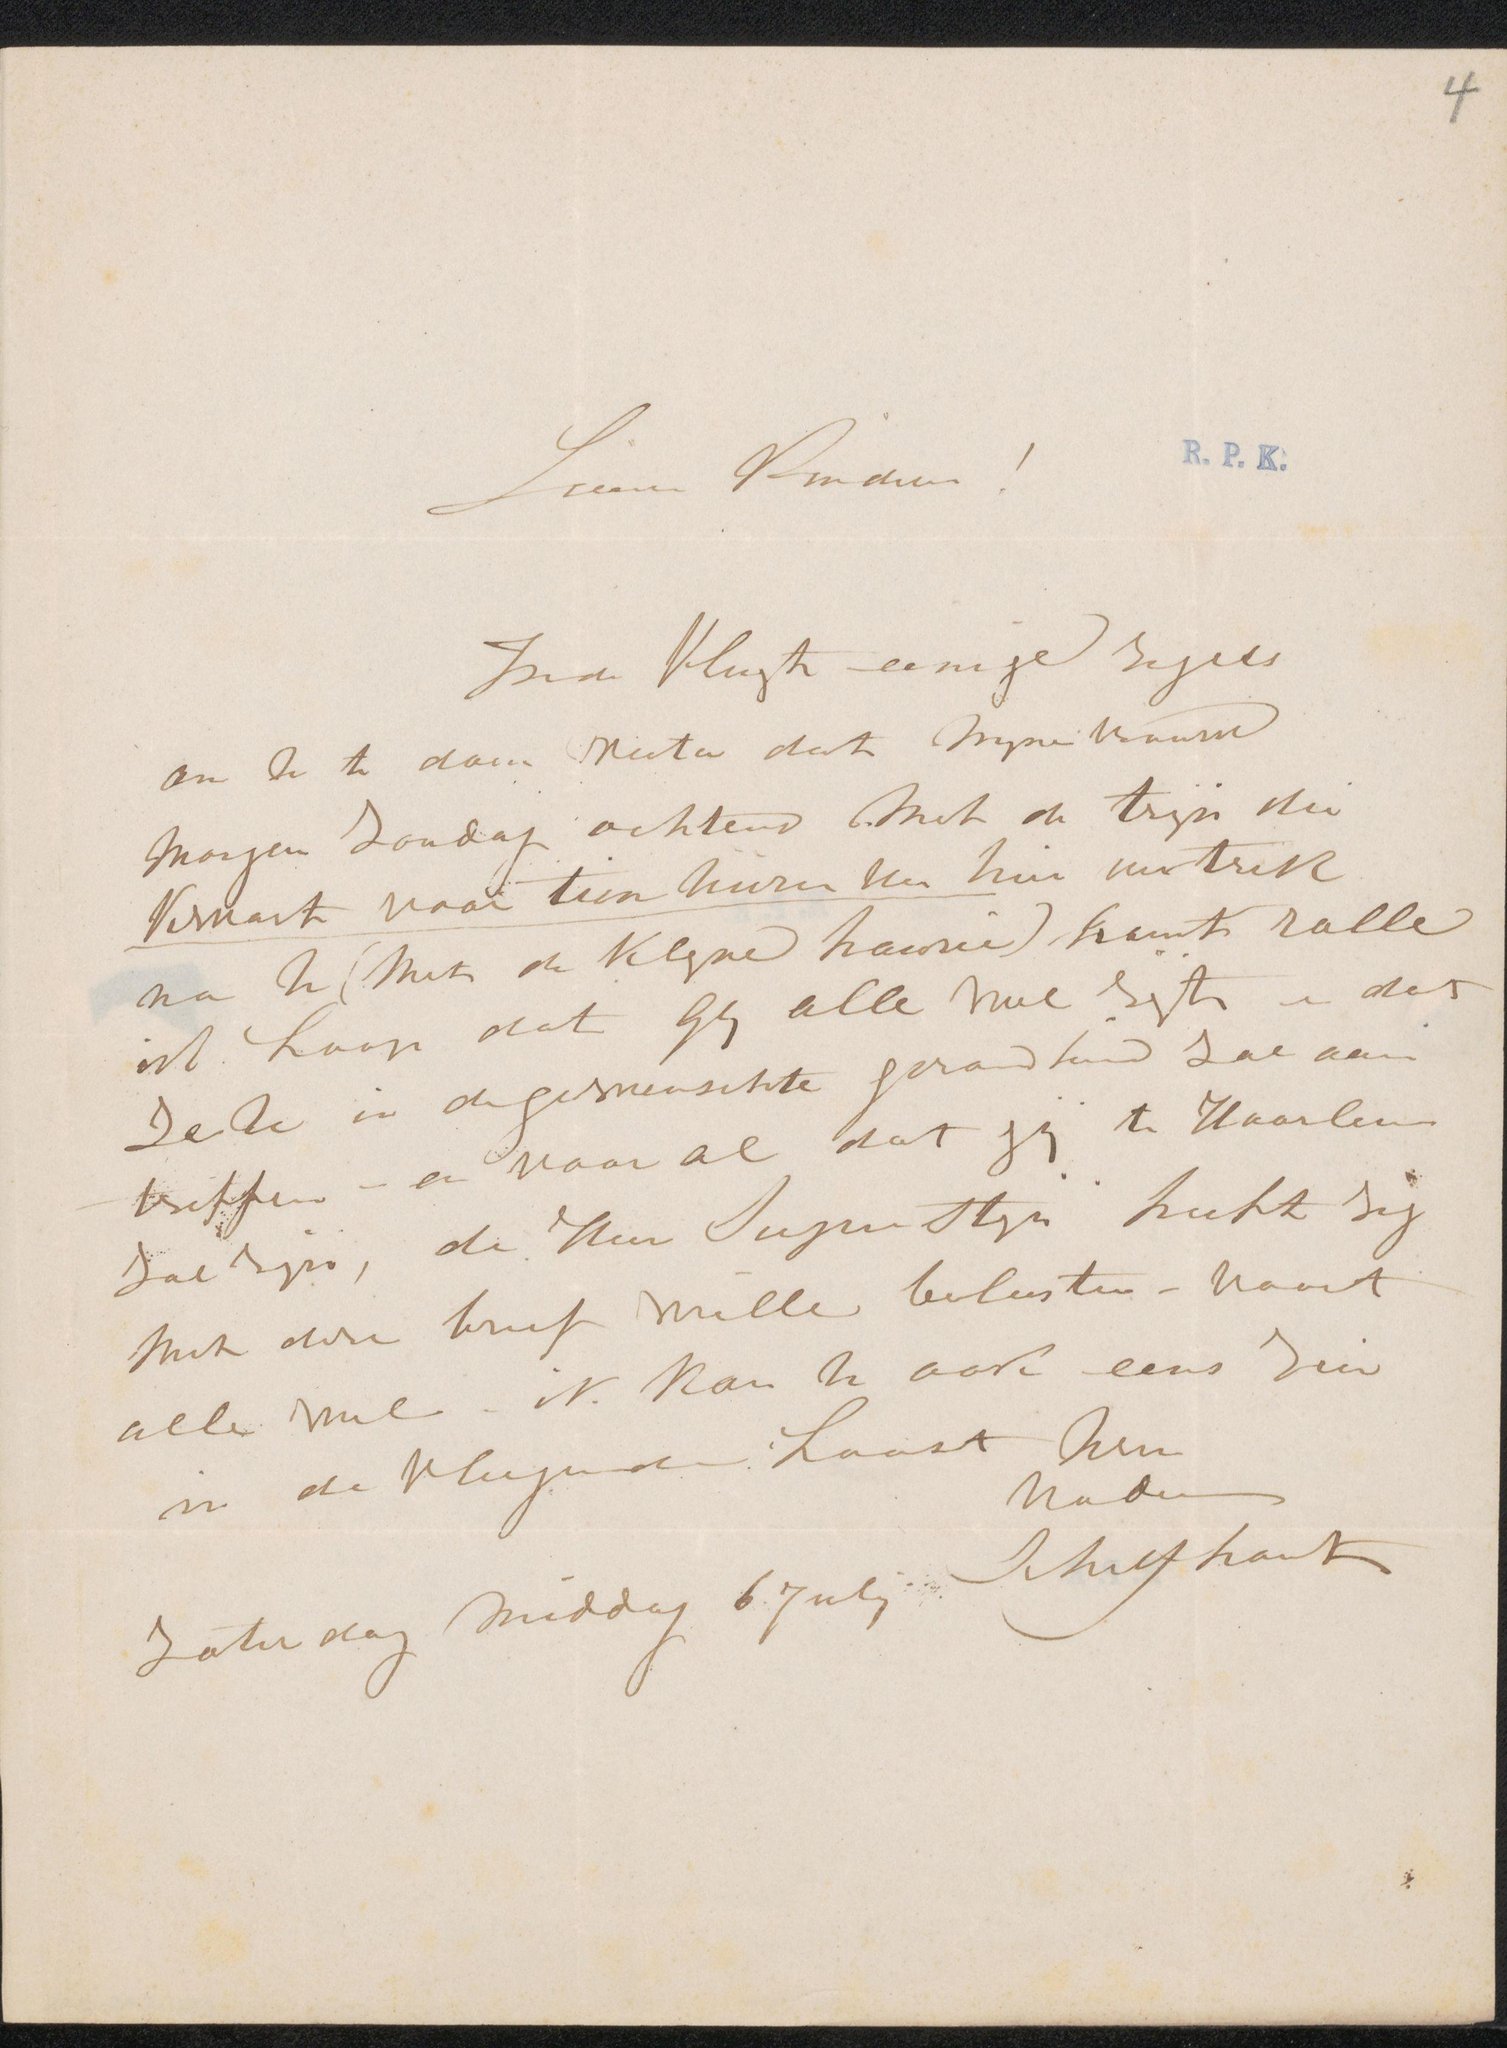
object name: letter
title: Brief aan Nicolaas Johannes Roosenboom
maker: andreas schelfhout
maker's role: draughtsman, painter, print maker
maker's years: 1787-1870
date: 1815-1870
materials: ink, paper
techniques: pen, writing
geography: the hague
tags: print maker, draughtsman, nicolaas johannes roosenboom, haarlem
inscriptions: collector's mark: Lugt 2233